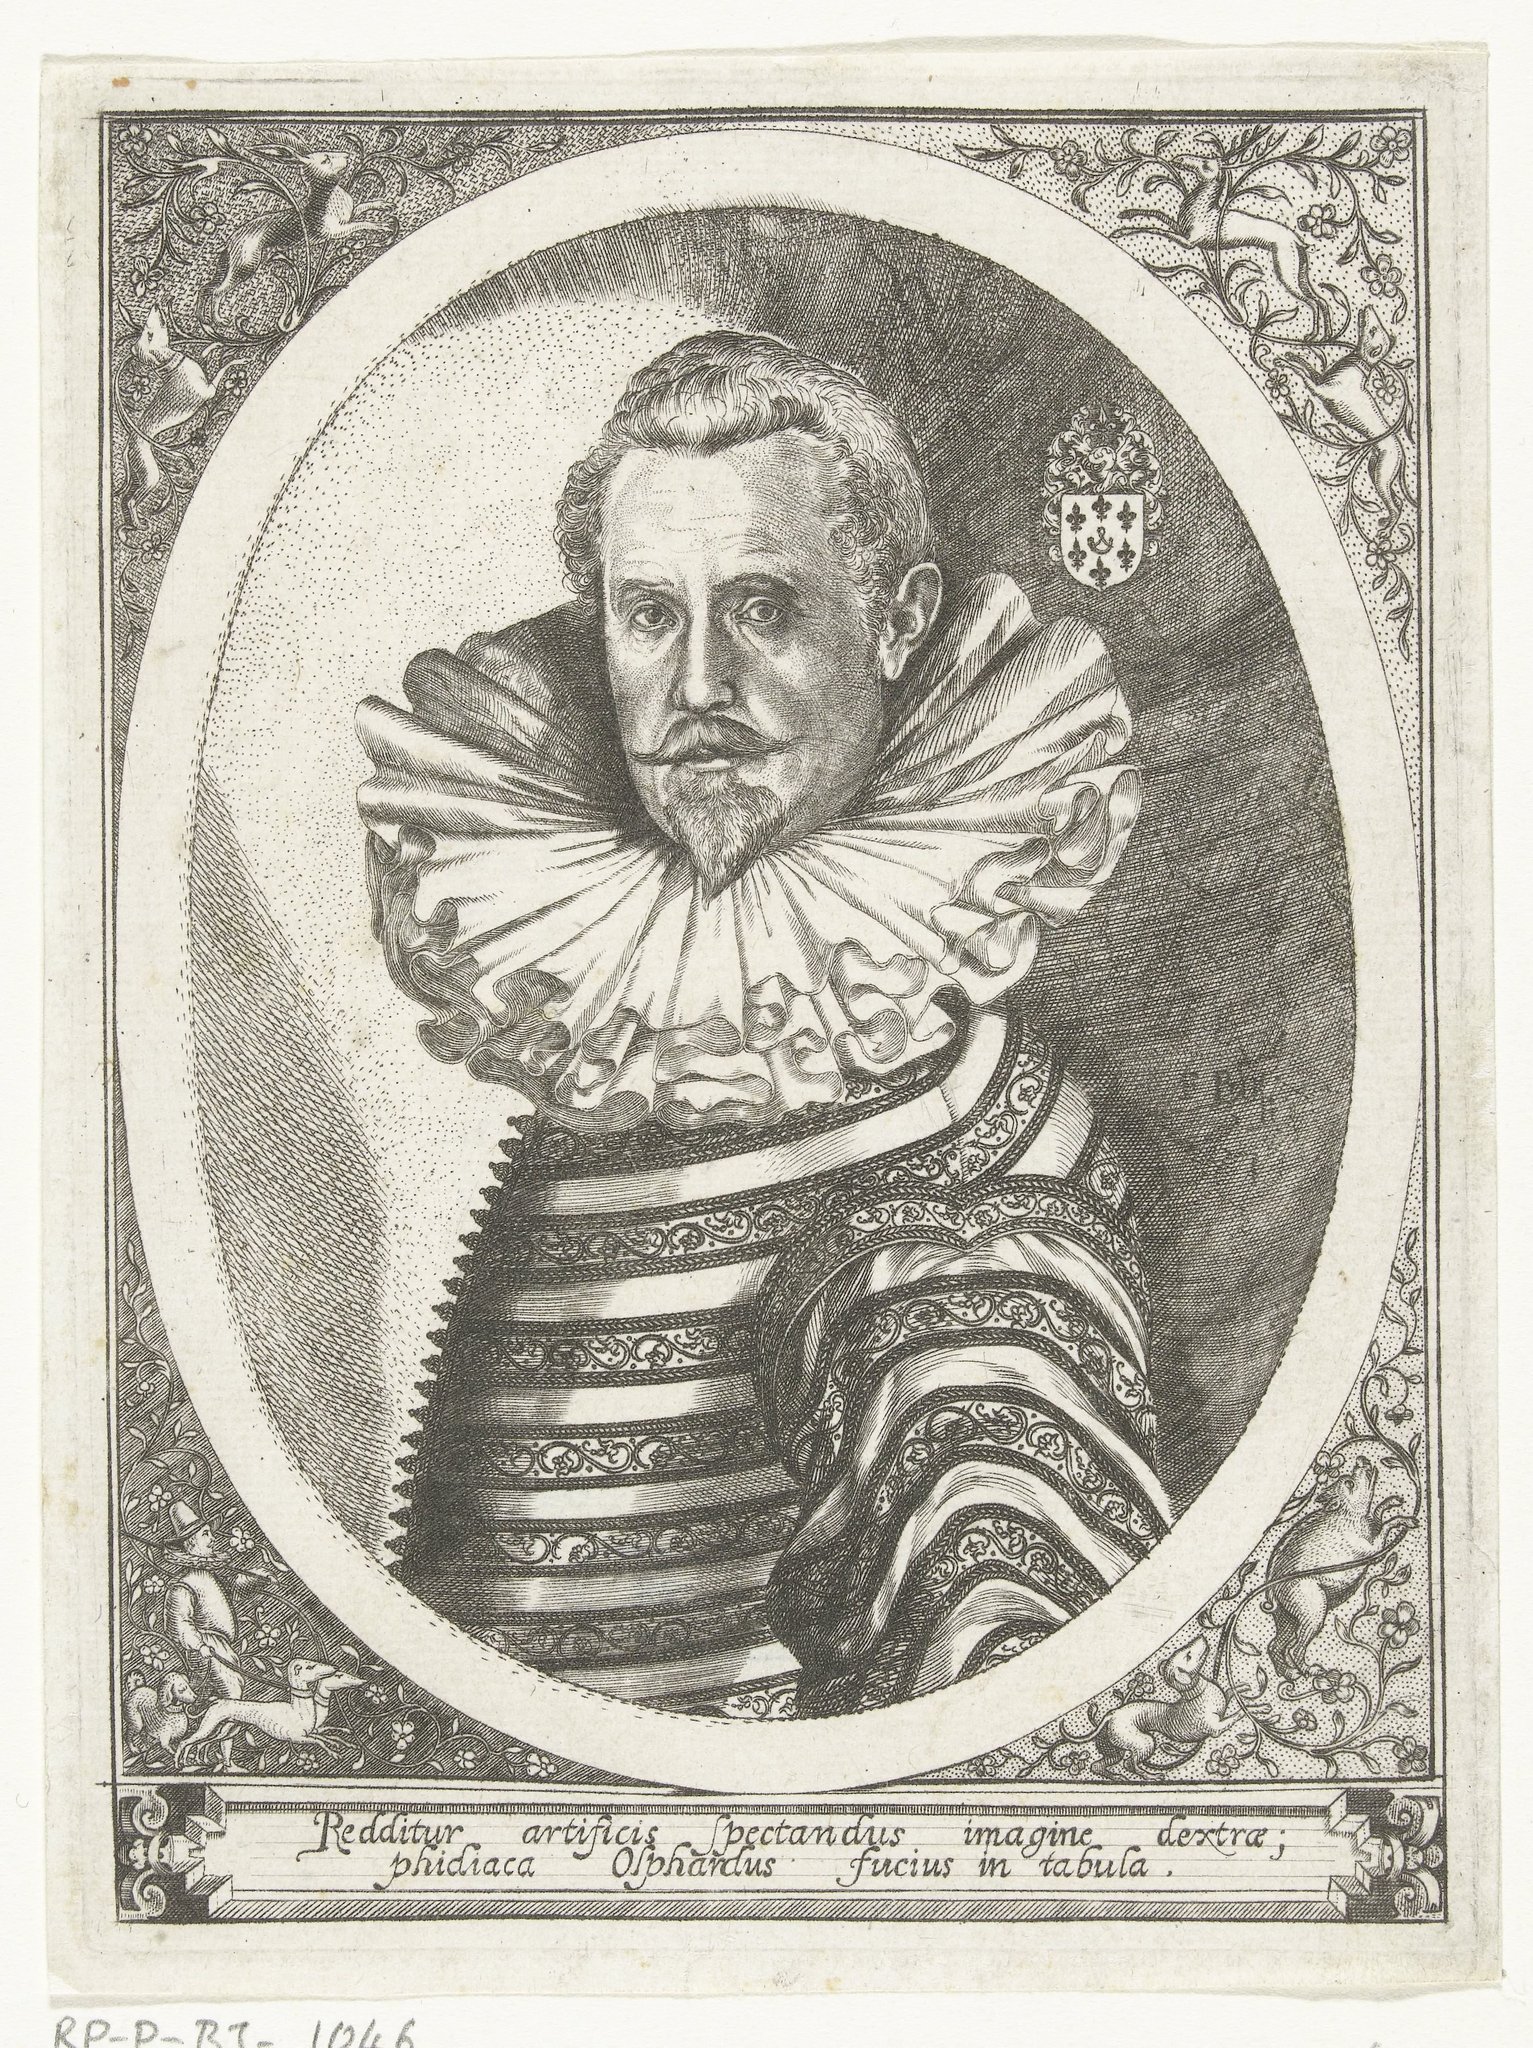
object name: print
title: Portret van Olpherdus Fuyck (Olfert Fuchs?)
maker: floris balthasarsz. van berckenrode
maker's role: print maker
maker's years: 1562-1616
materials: paper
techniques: engraving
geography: delft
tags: neck-gear: collar (+ men's clothes)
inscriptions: collector's mark: Lugt 2228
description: Portret van de edelman Olpherdus Fuyck (Olfert Fuchs?) in ovaal met een grote plooikraag om. Rechts boven zijn wapen. Met een onderschrift van twee regels in het Latijn.